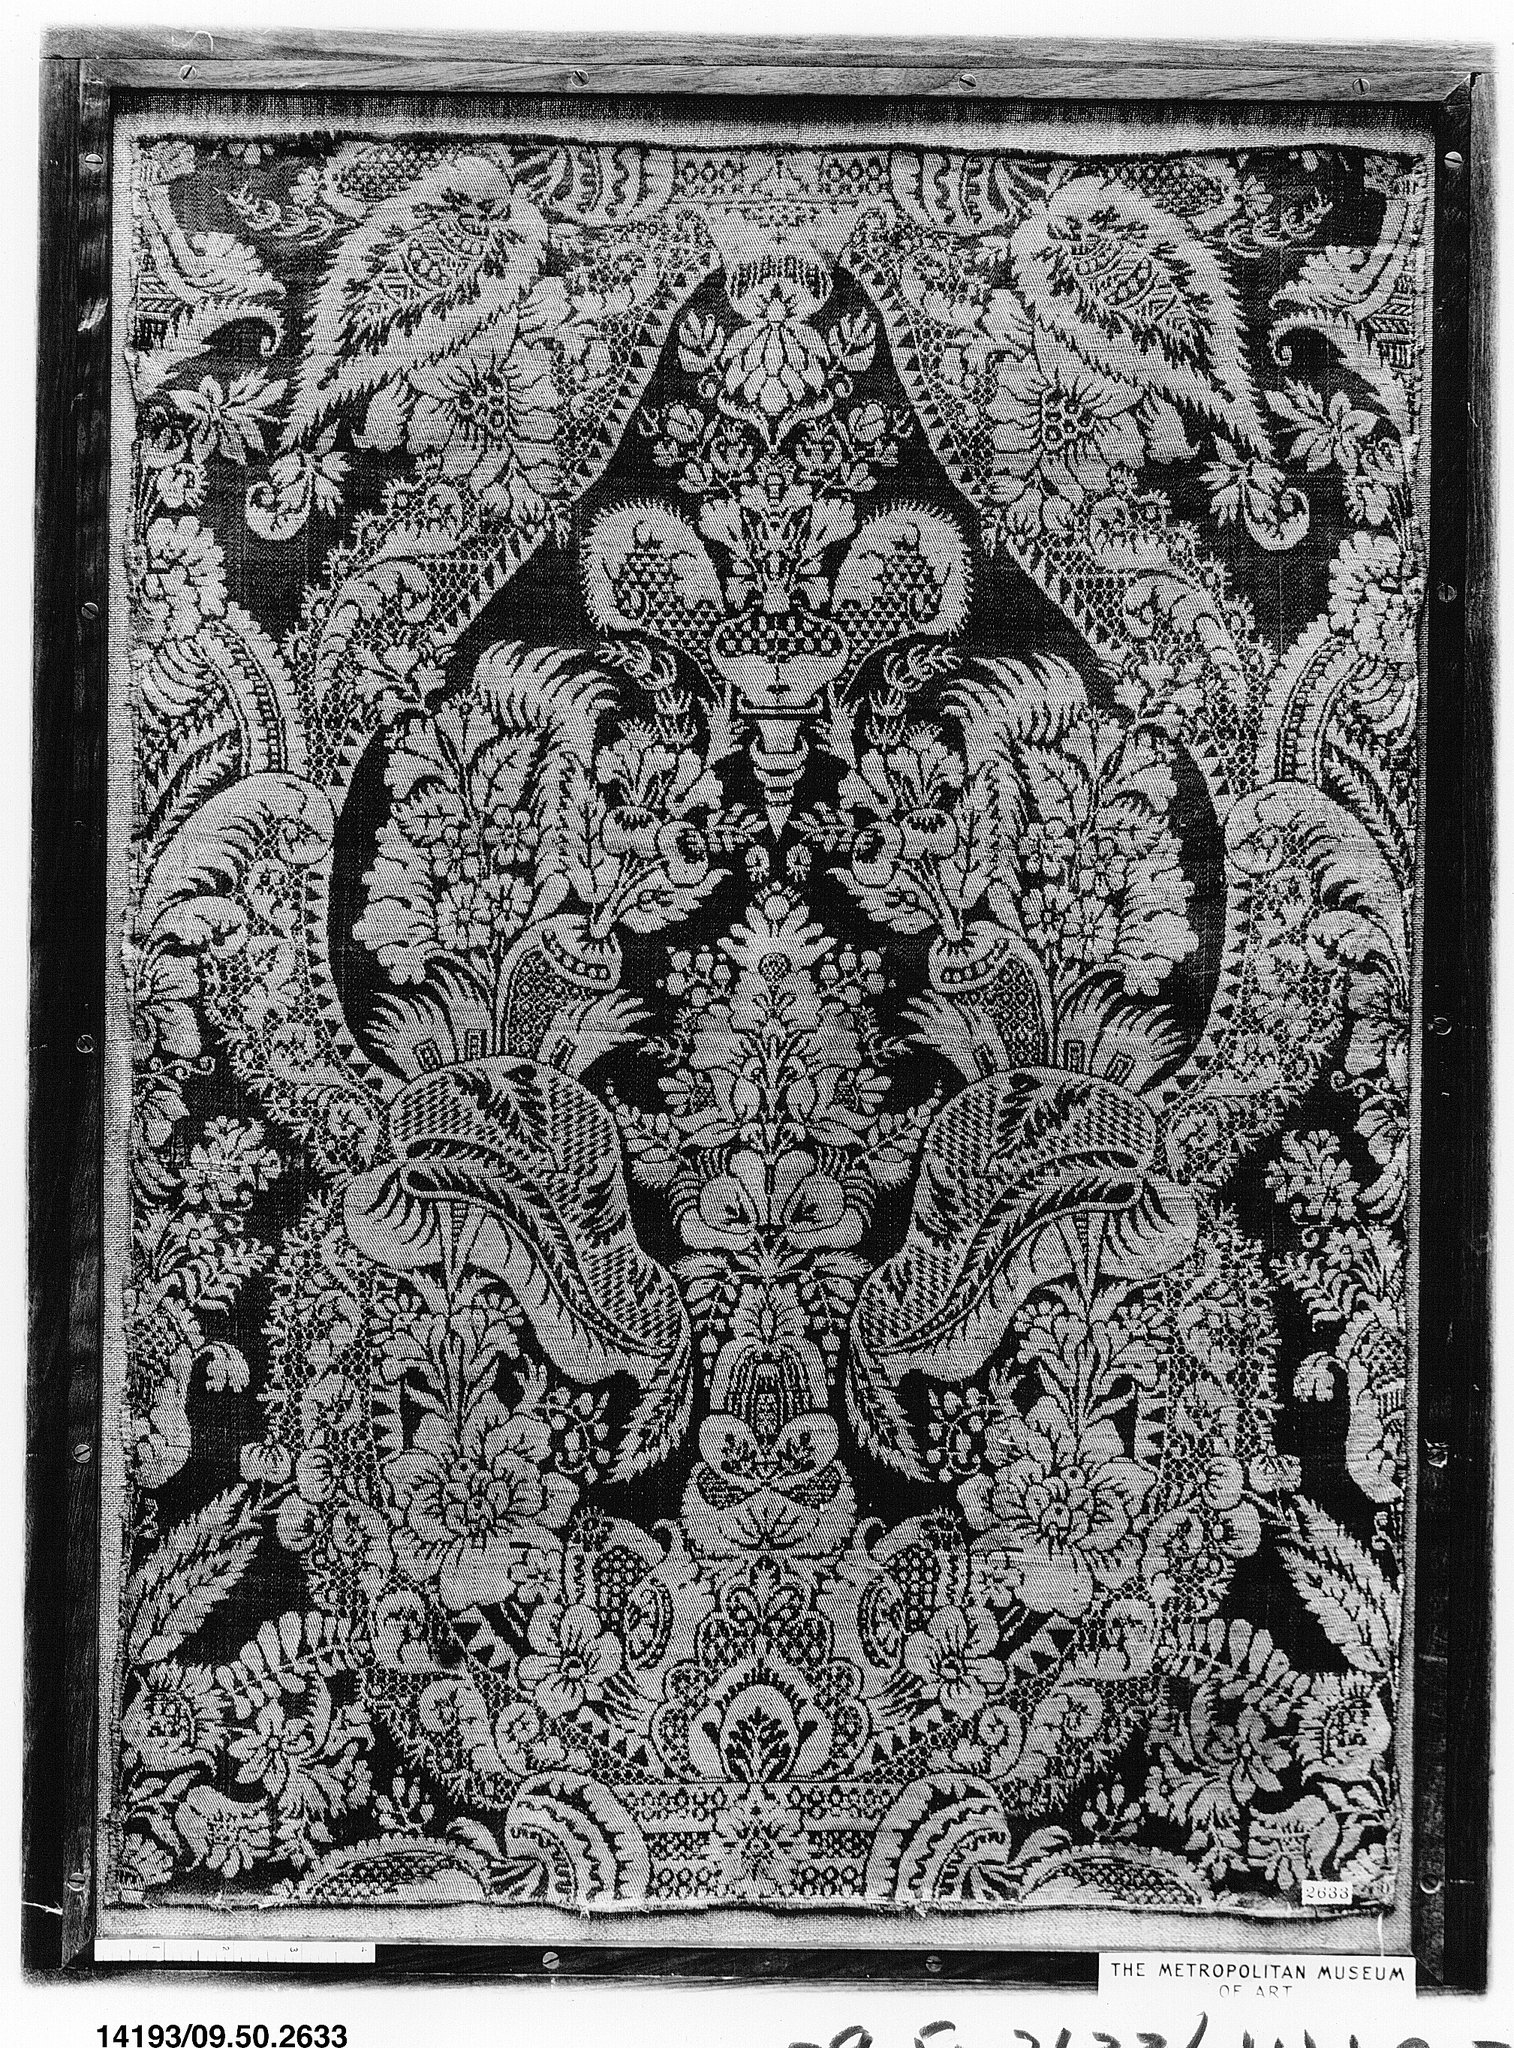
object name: piece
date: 1720-1725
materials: linen, silk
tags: flowers,leaves